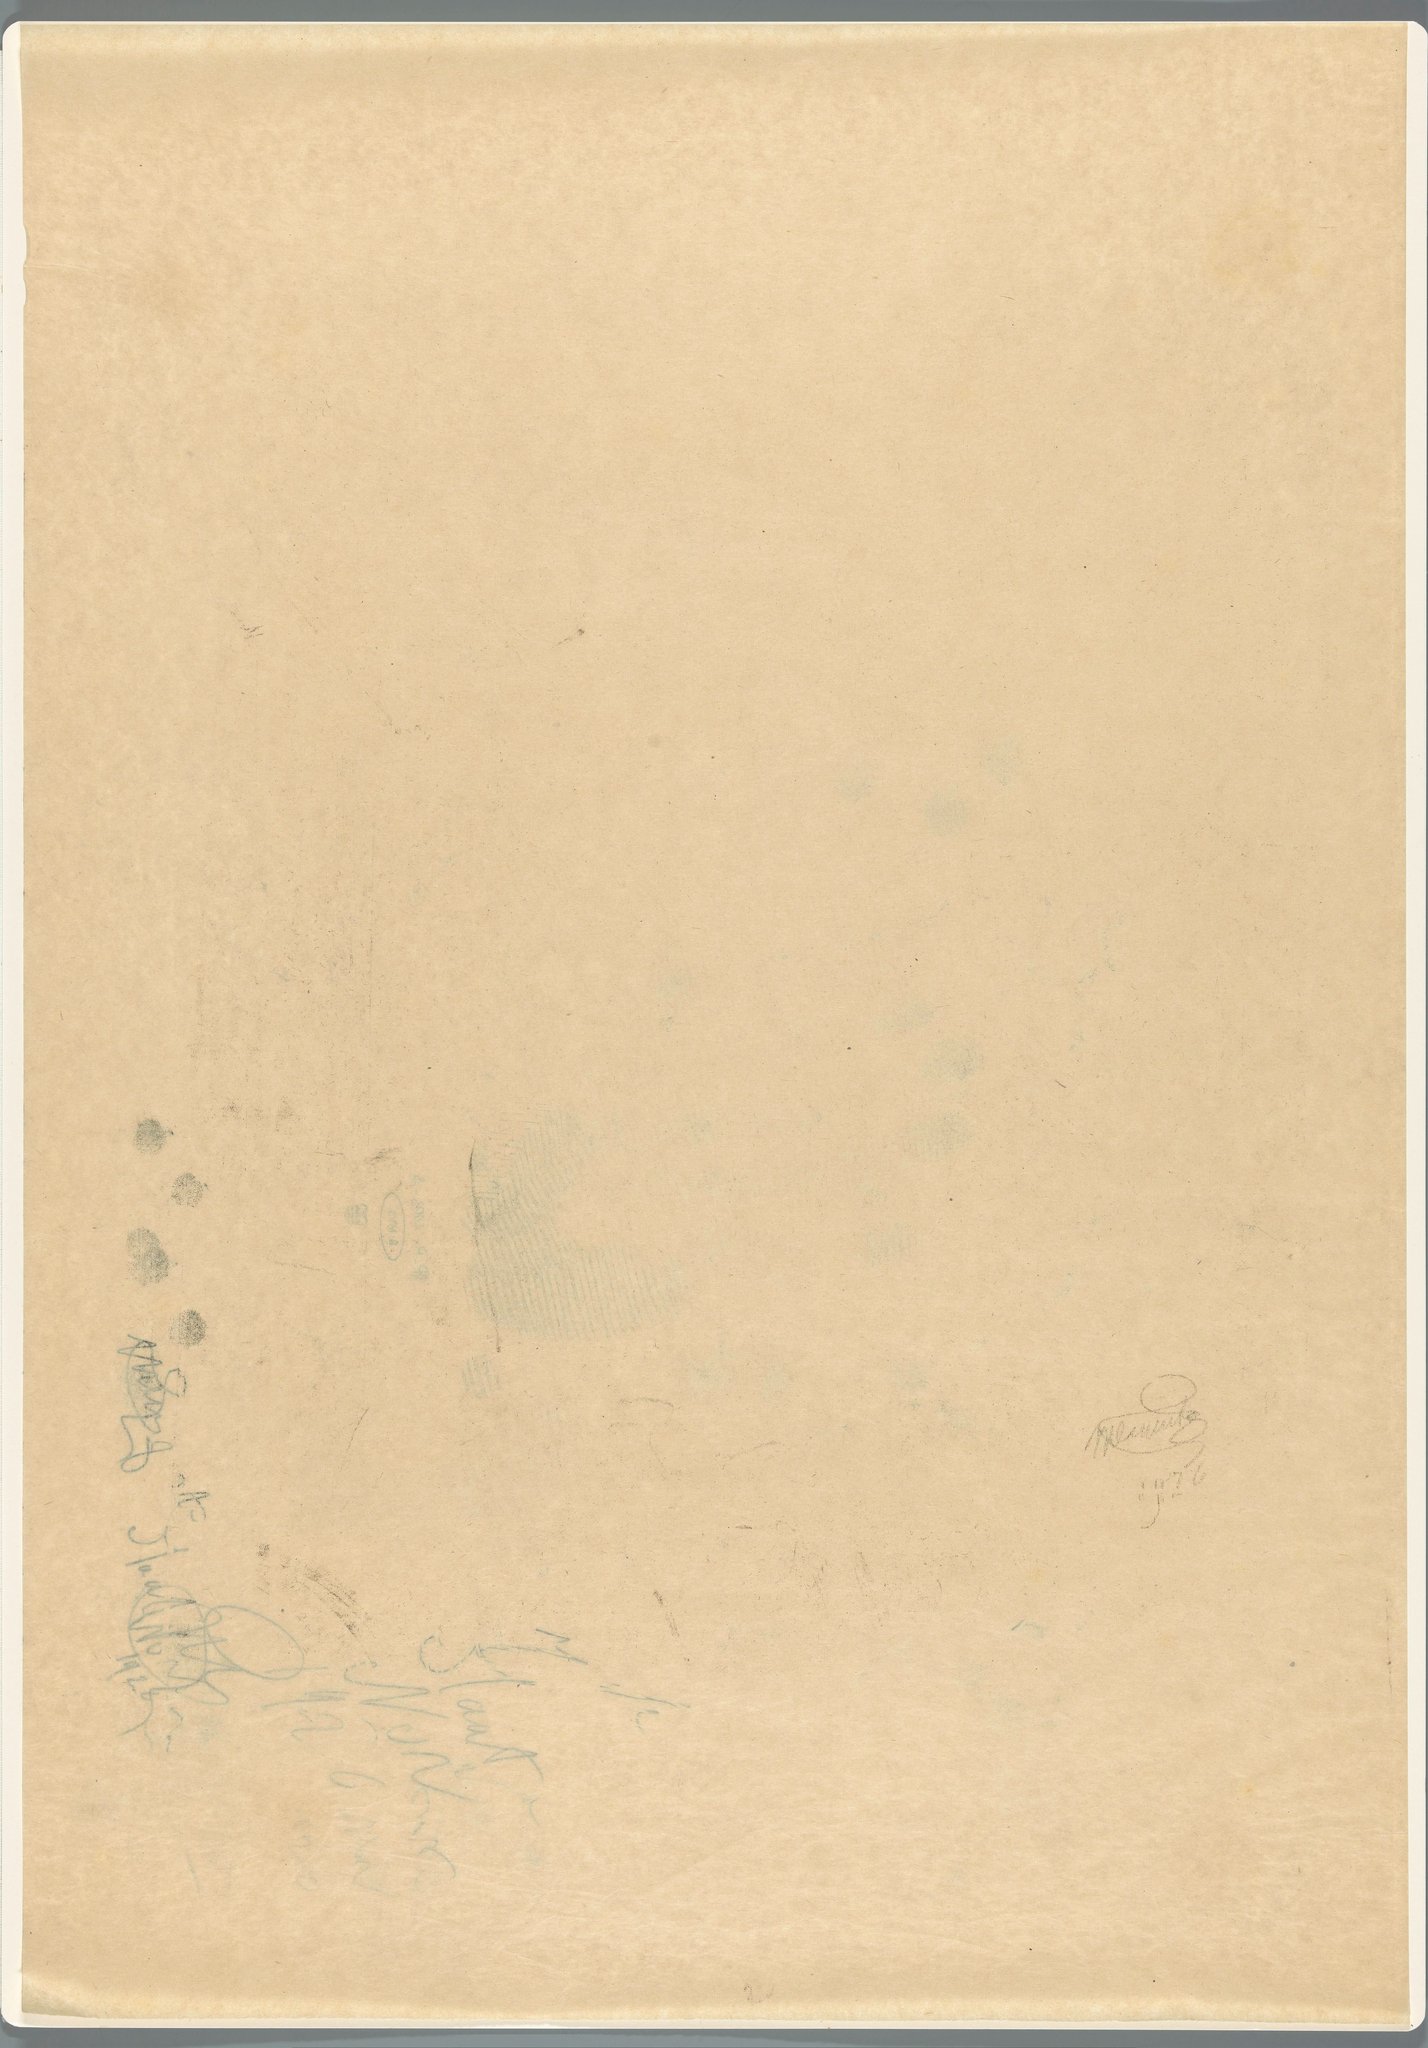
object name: print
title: Memento Mori (zelfportret met schedel)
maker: samuel jessurun de mesquita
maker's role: draughtsman, print maker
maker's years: 1868-1944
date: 1911-1926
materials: paper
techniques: woodcut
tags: draughtsman, samuel jessurun de mesquita, portrait, self-portrait of artist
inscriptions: collector's mark: Lugt 2228, collector's mark: Lugt 2760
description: Bij de prent is een blad opgezet met daarop signatuur en datering.